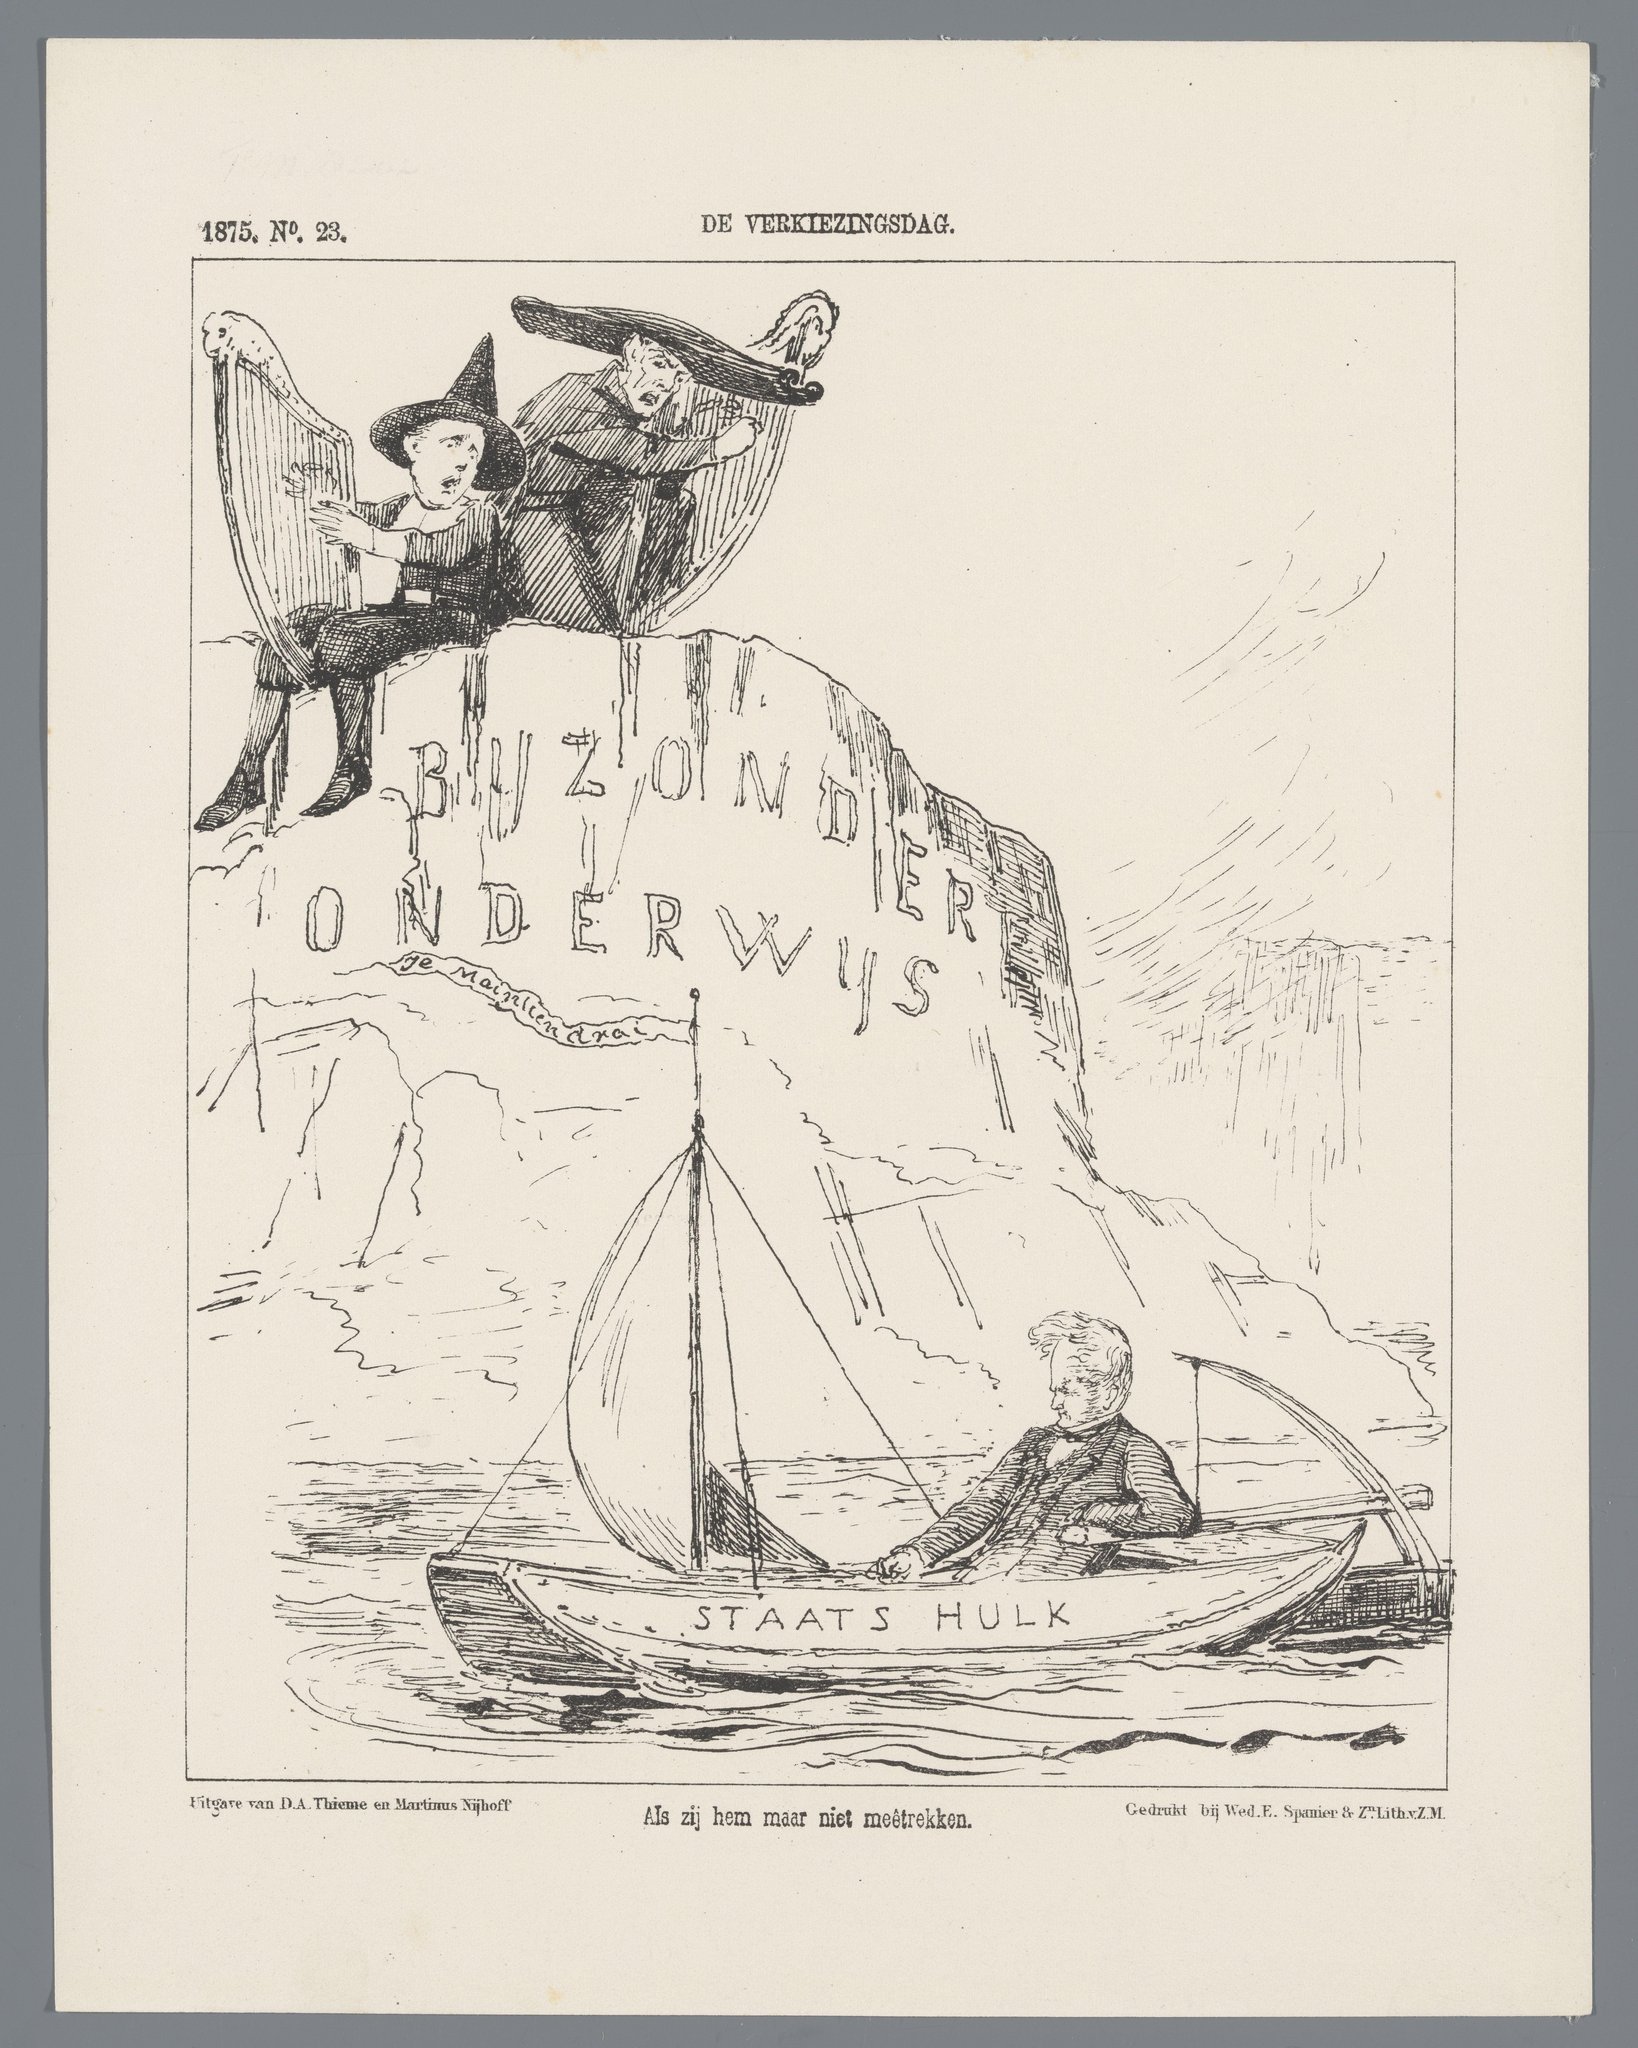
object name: print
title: Spotprent op de verleidingstactieken van de confessionele partijen, 1875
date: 1875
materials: paper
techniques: lithograph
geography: netherlands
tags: tweede kamerlid, minister van binnenlandse zaken, minister van justitie, jan heemskerk azn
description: Spotprent op de verleidingstactieken van de confessionele partijen die als de Lorelei Heemskerk met hun muziek proberen te lokken. Plaat verschenen bij het weekblad De Nederlandsche Spectator, nr. 23, 1875.